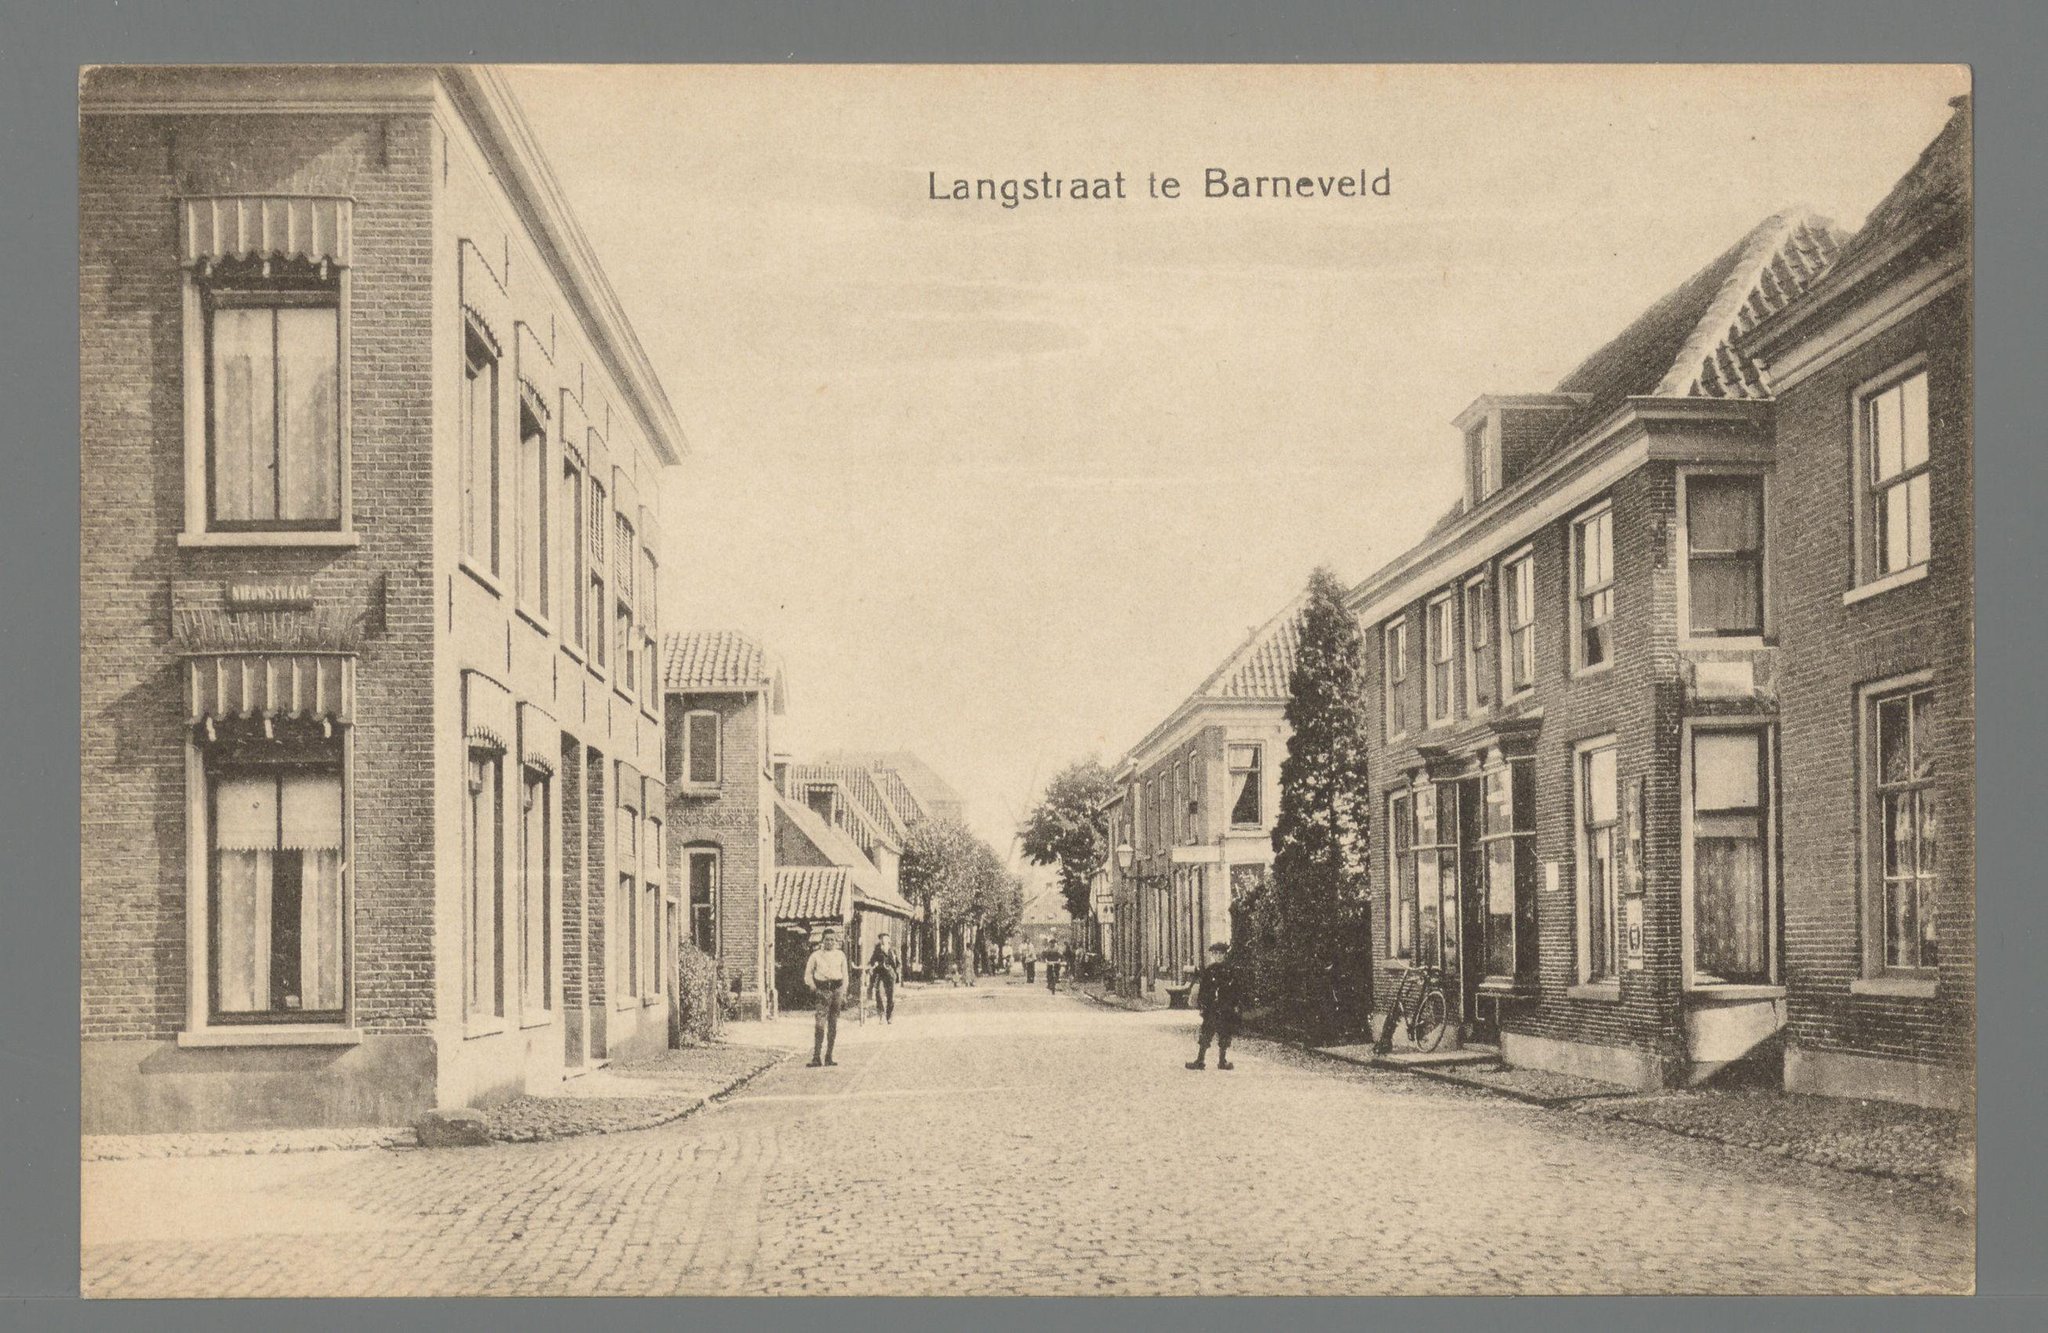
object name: photomechanical print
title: Langstraat te Barneveld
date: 1918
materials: cardboard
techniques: photograph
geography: barneveld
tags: street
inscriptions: date